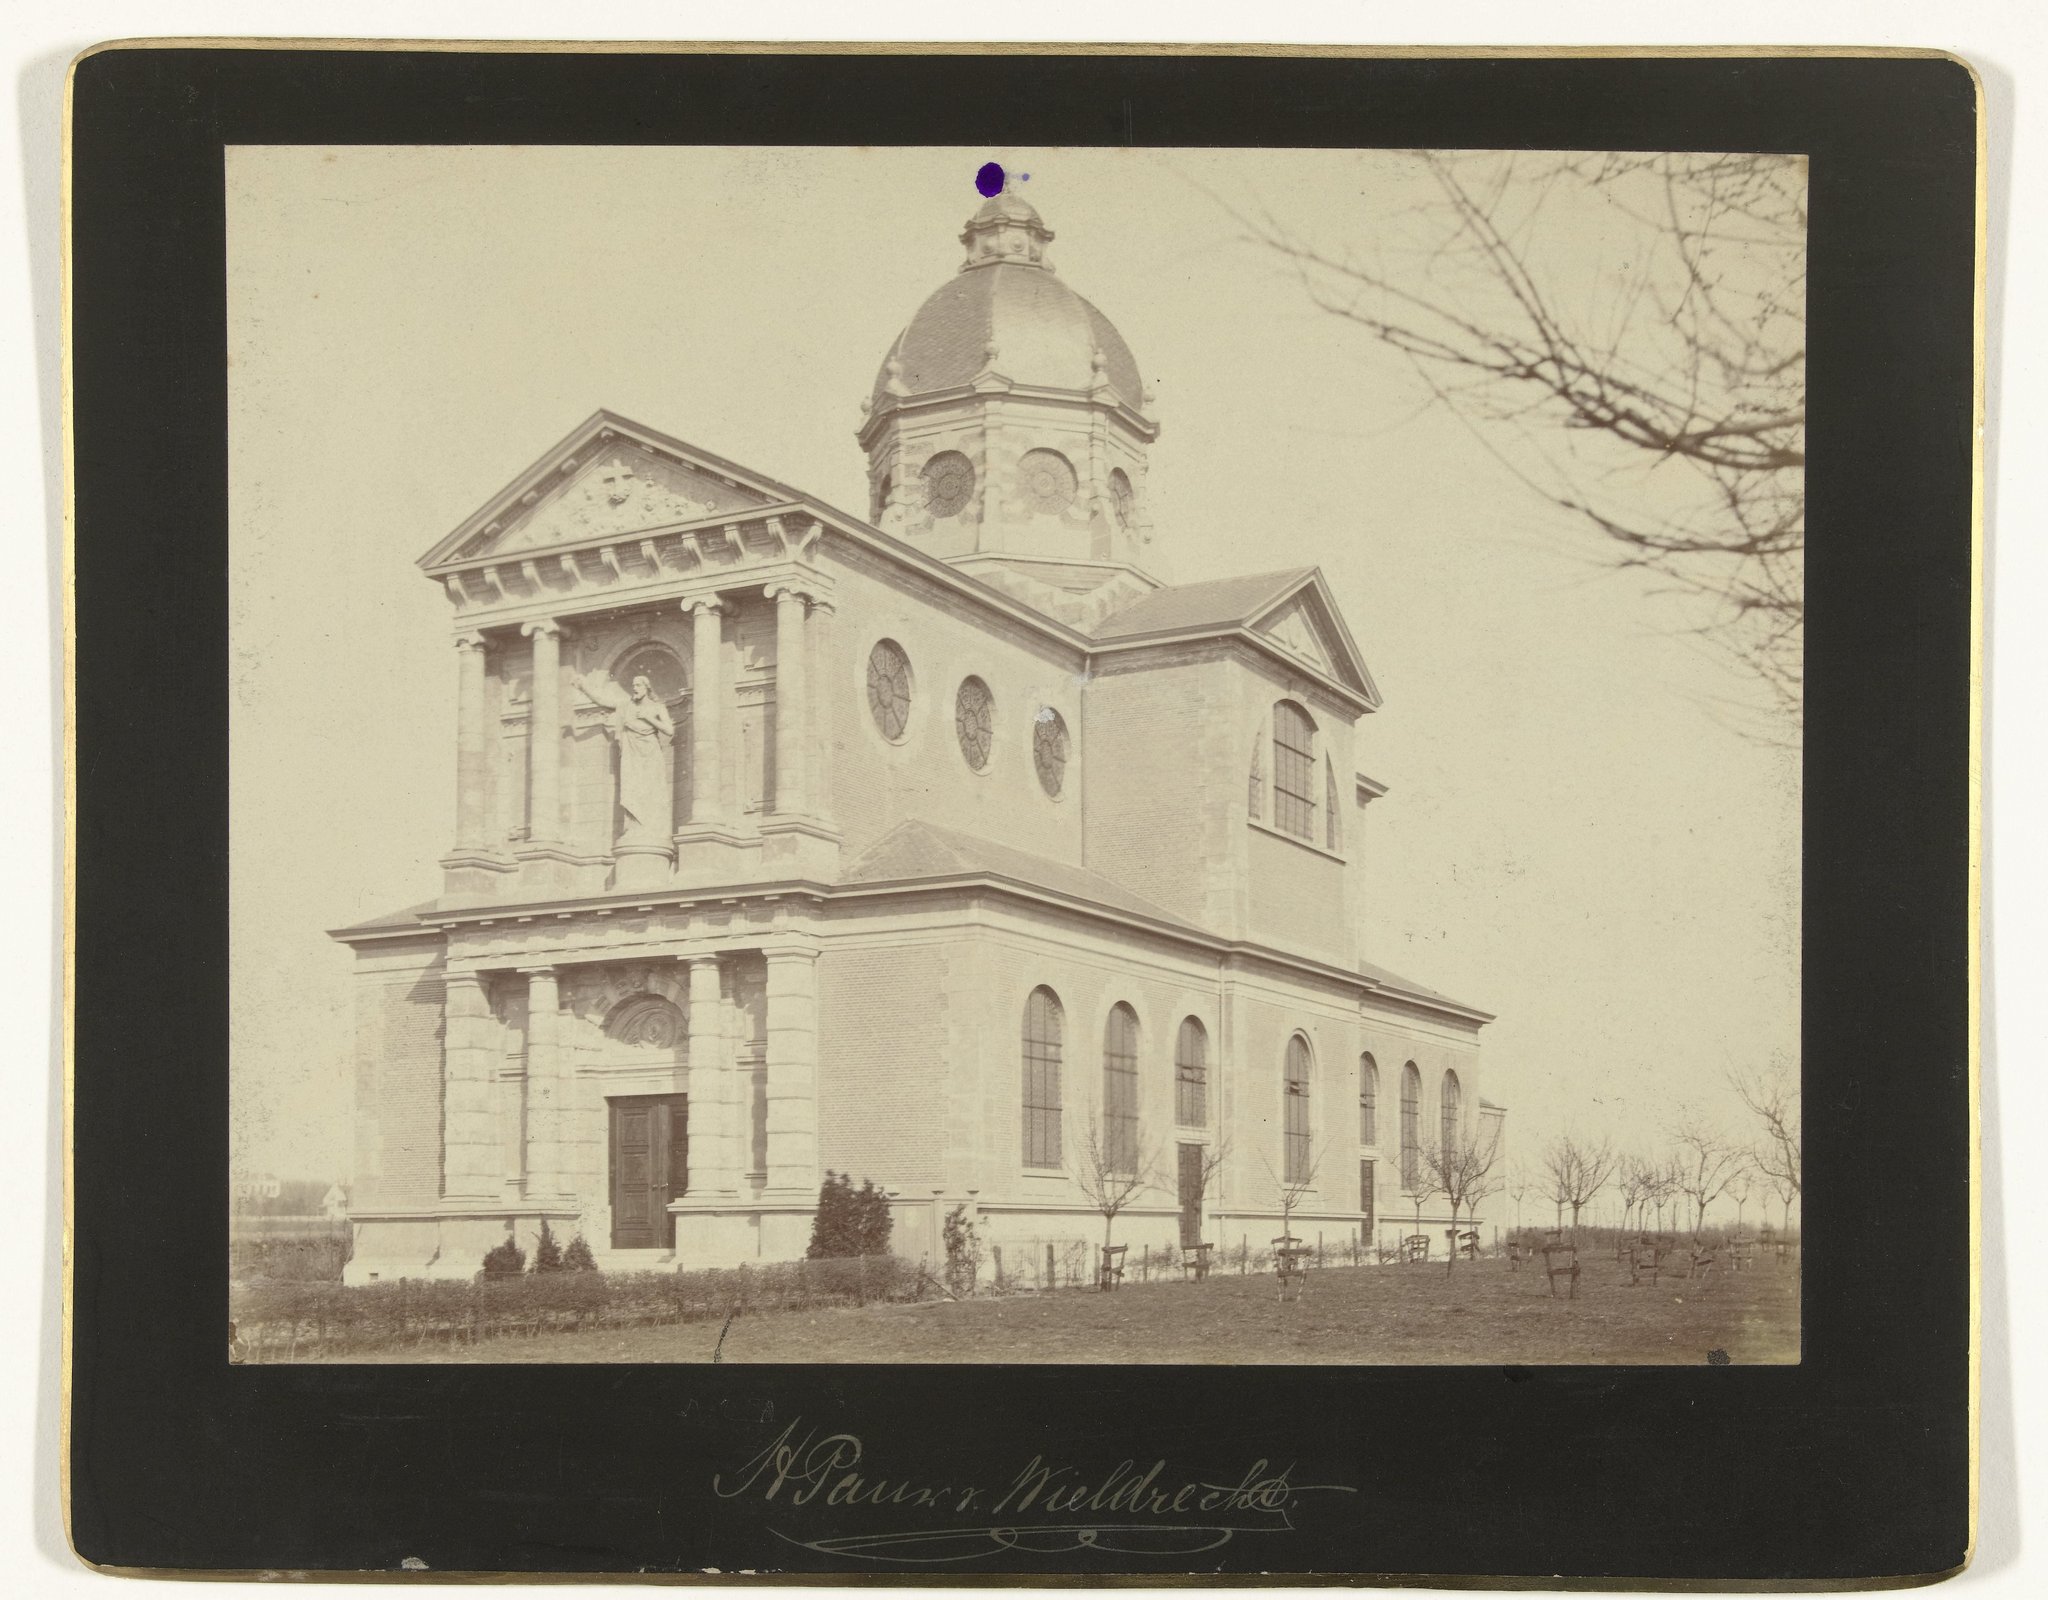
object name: photograph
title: Kerk met koepel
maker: henry pauw van wieldrecht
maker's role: fotograaf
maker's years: 1863-1912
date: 1892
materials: cardboard, photographic support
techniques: albumen print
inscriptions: signature: ‘H Pauw v. Wieldrecht’, annotation: ‘No. 32. 509. 1892.’